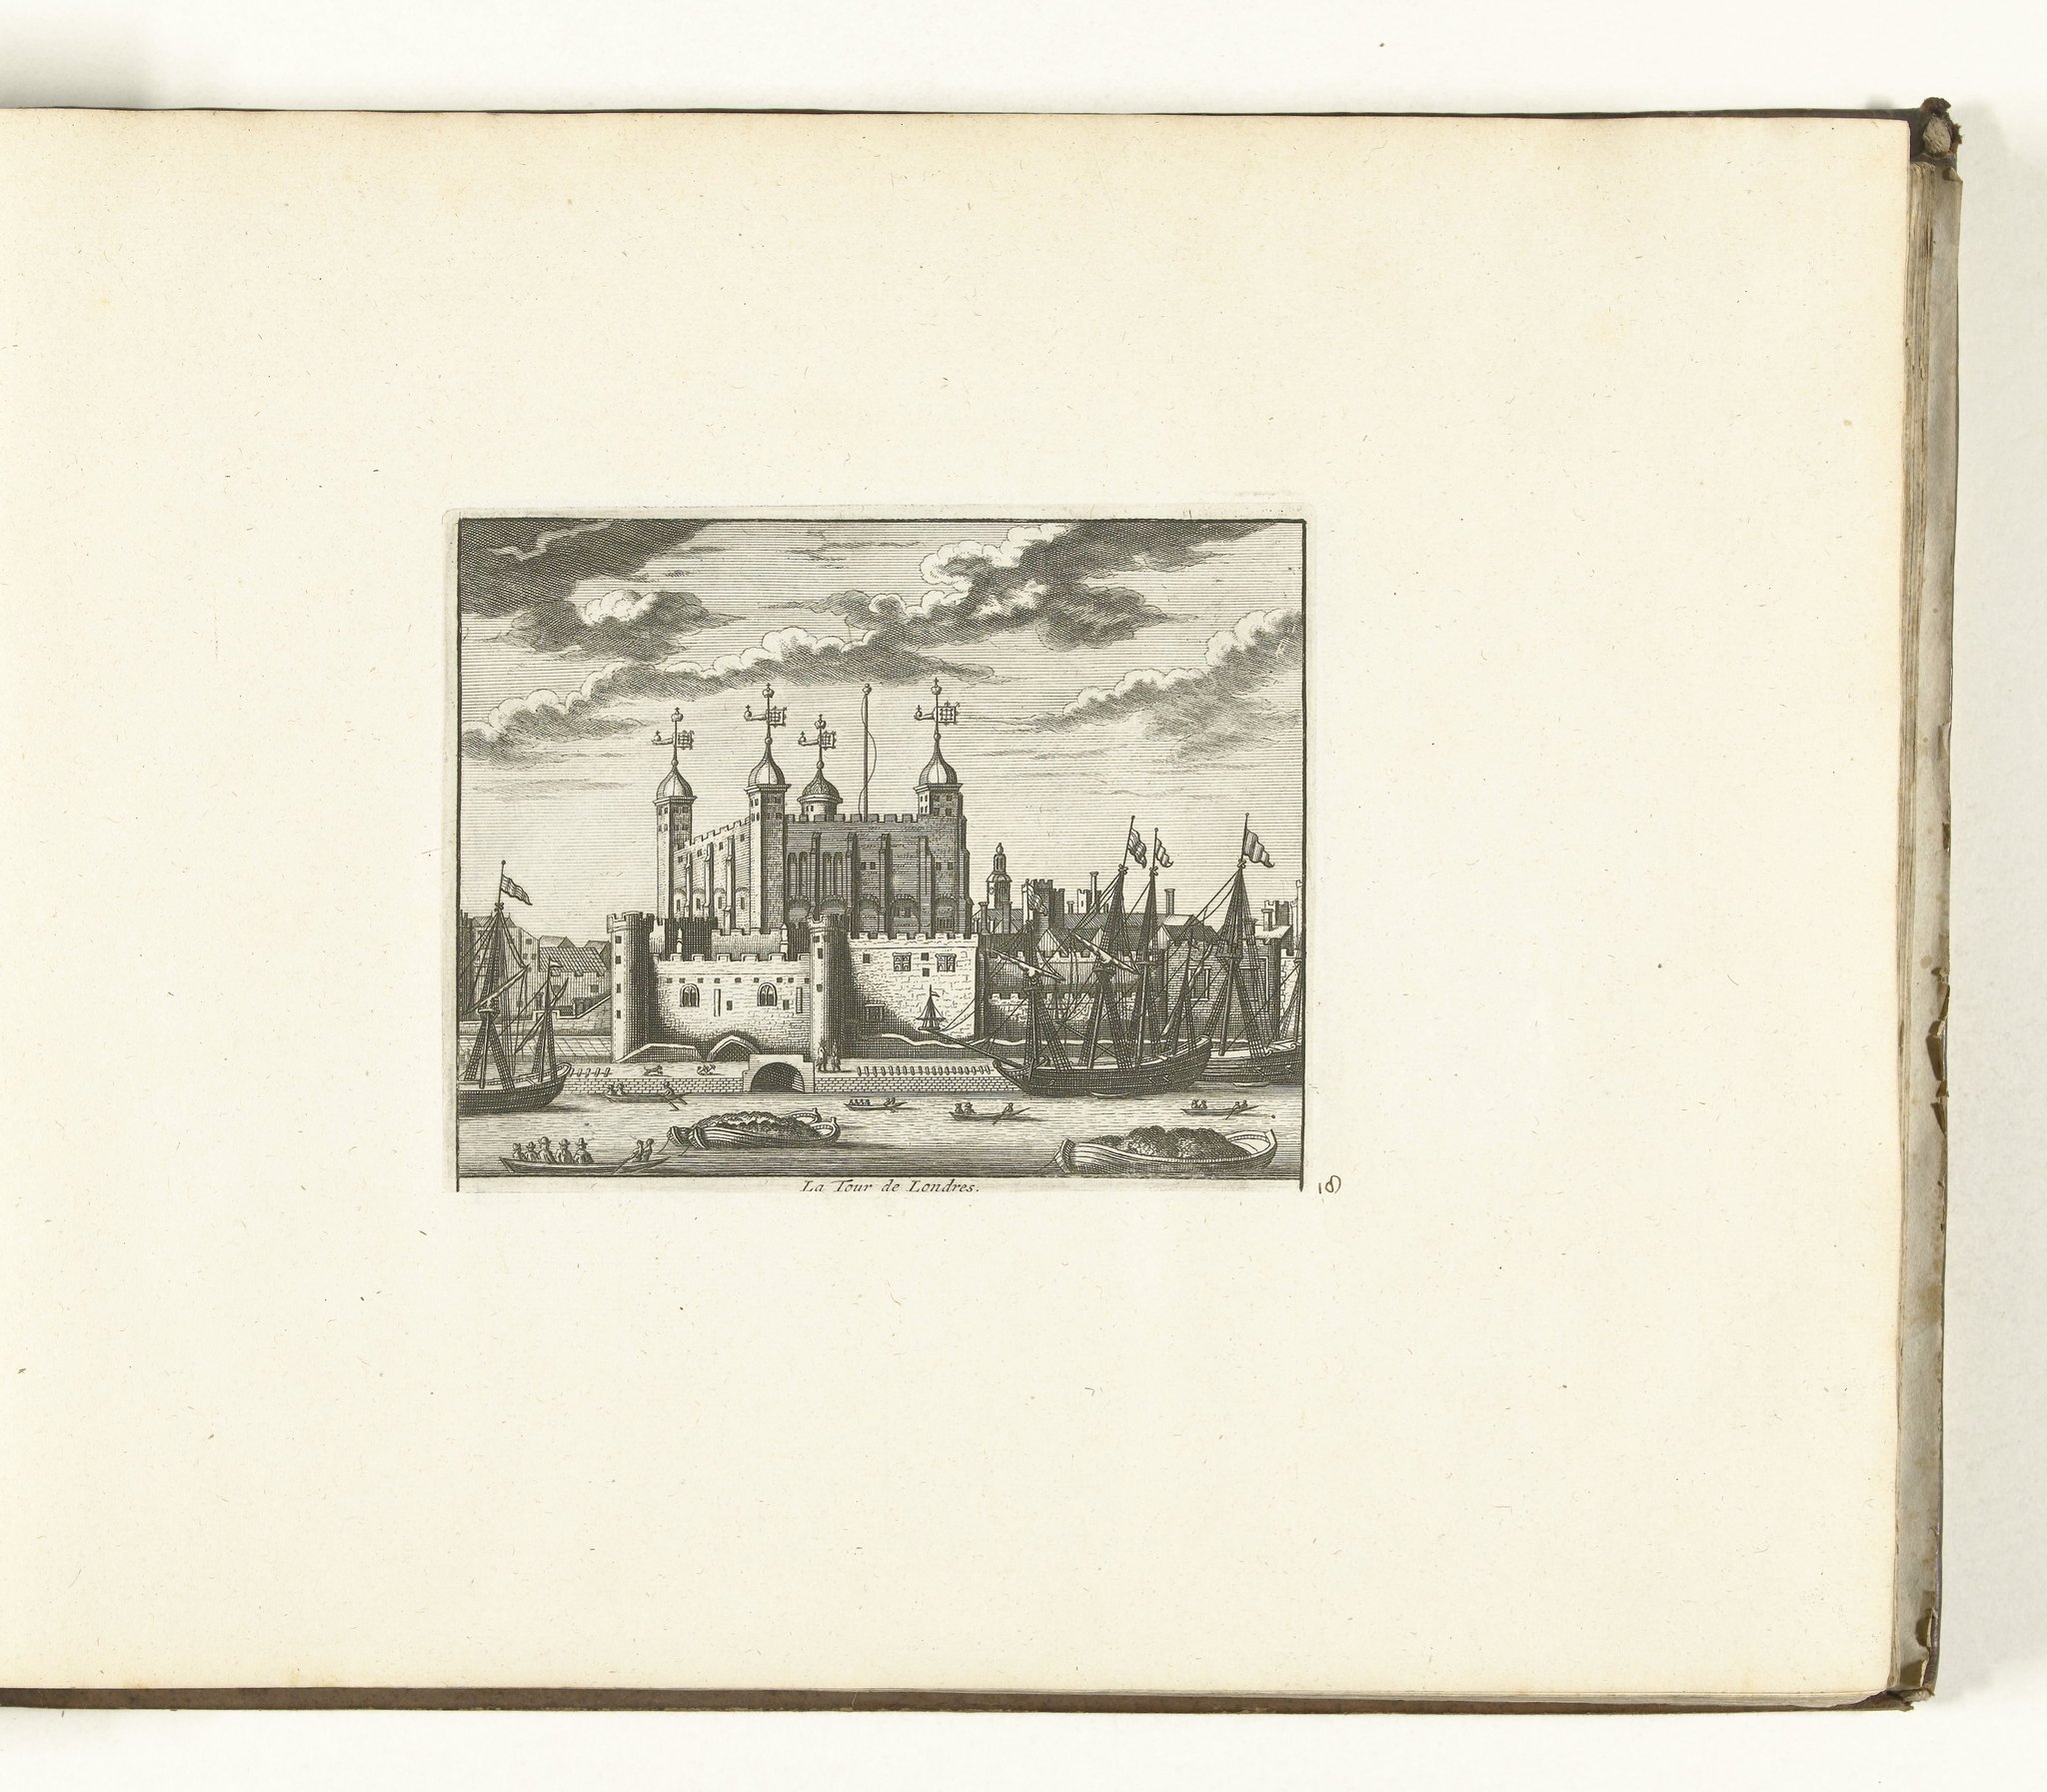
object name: print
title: Les Forces de l'Europe, Asie, Afrique et Amerique (...) Comme aussi les Cartes des Côtes de France et d'Espagne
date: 1726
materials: paper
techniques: etching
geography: leiden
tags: tower of london, spaanse successieoorlog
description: Gezicht op de Tower te Londen. Plaat nr. 18 in deel I van het prentwerk: Les Forces de l'Europe, Asie, Afrique et Amerique ... Comme aussi les Cartes des Côtes de France et d'Espagne uit 1726, dit eerste deel met 238 met de hand genummerde platen van vermaarde sterke steden en vestingen in het kader van de Spaanse Successieoorlog 1701-1713. Voor het merendeel zijn deze platen gekopieerd naar de anonieme Franse platen van vermaarde sterke steden en vestingen: in Les forces de l'Europe en in: Le theatre de la guerre, dans les Pays-Bas, beide oorspronkelijk uitgegeven door Nicolas de Fer te Parijs (1693-1697) in het kader van de Negenjarige Oorlog. Titel in het Frans.